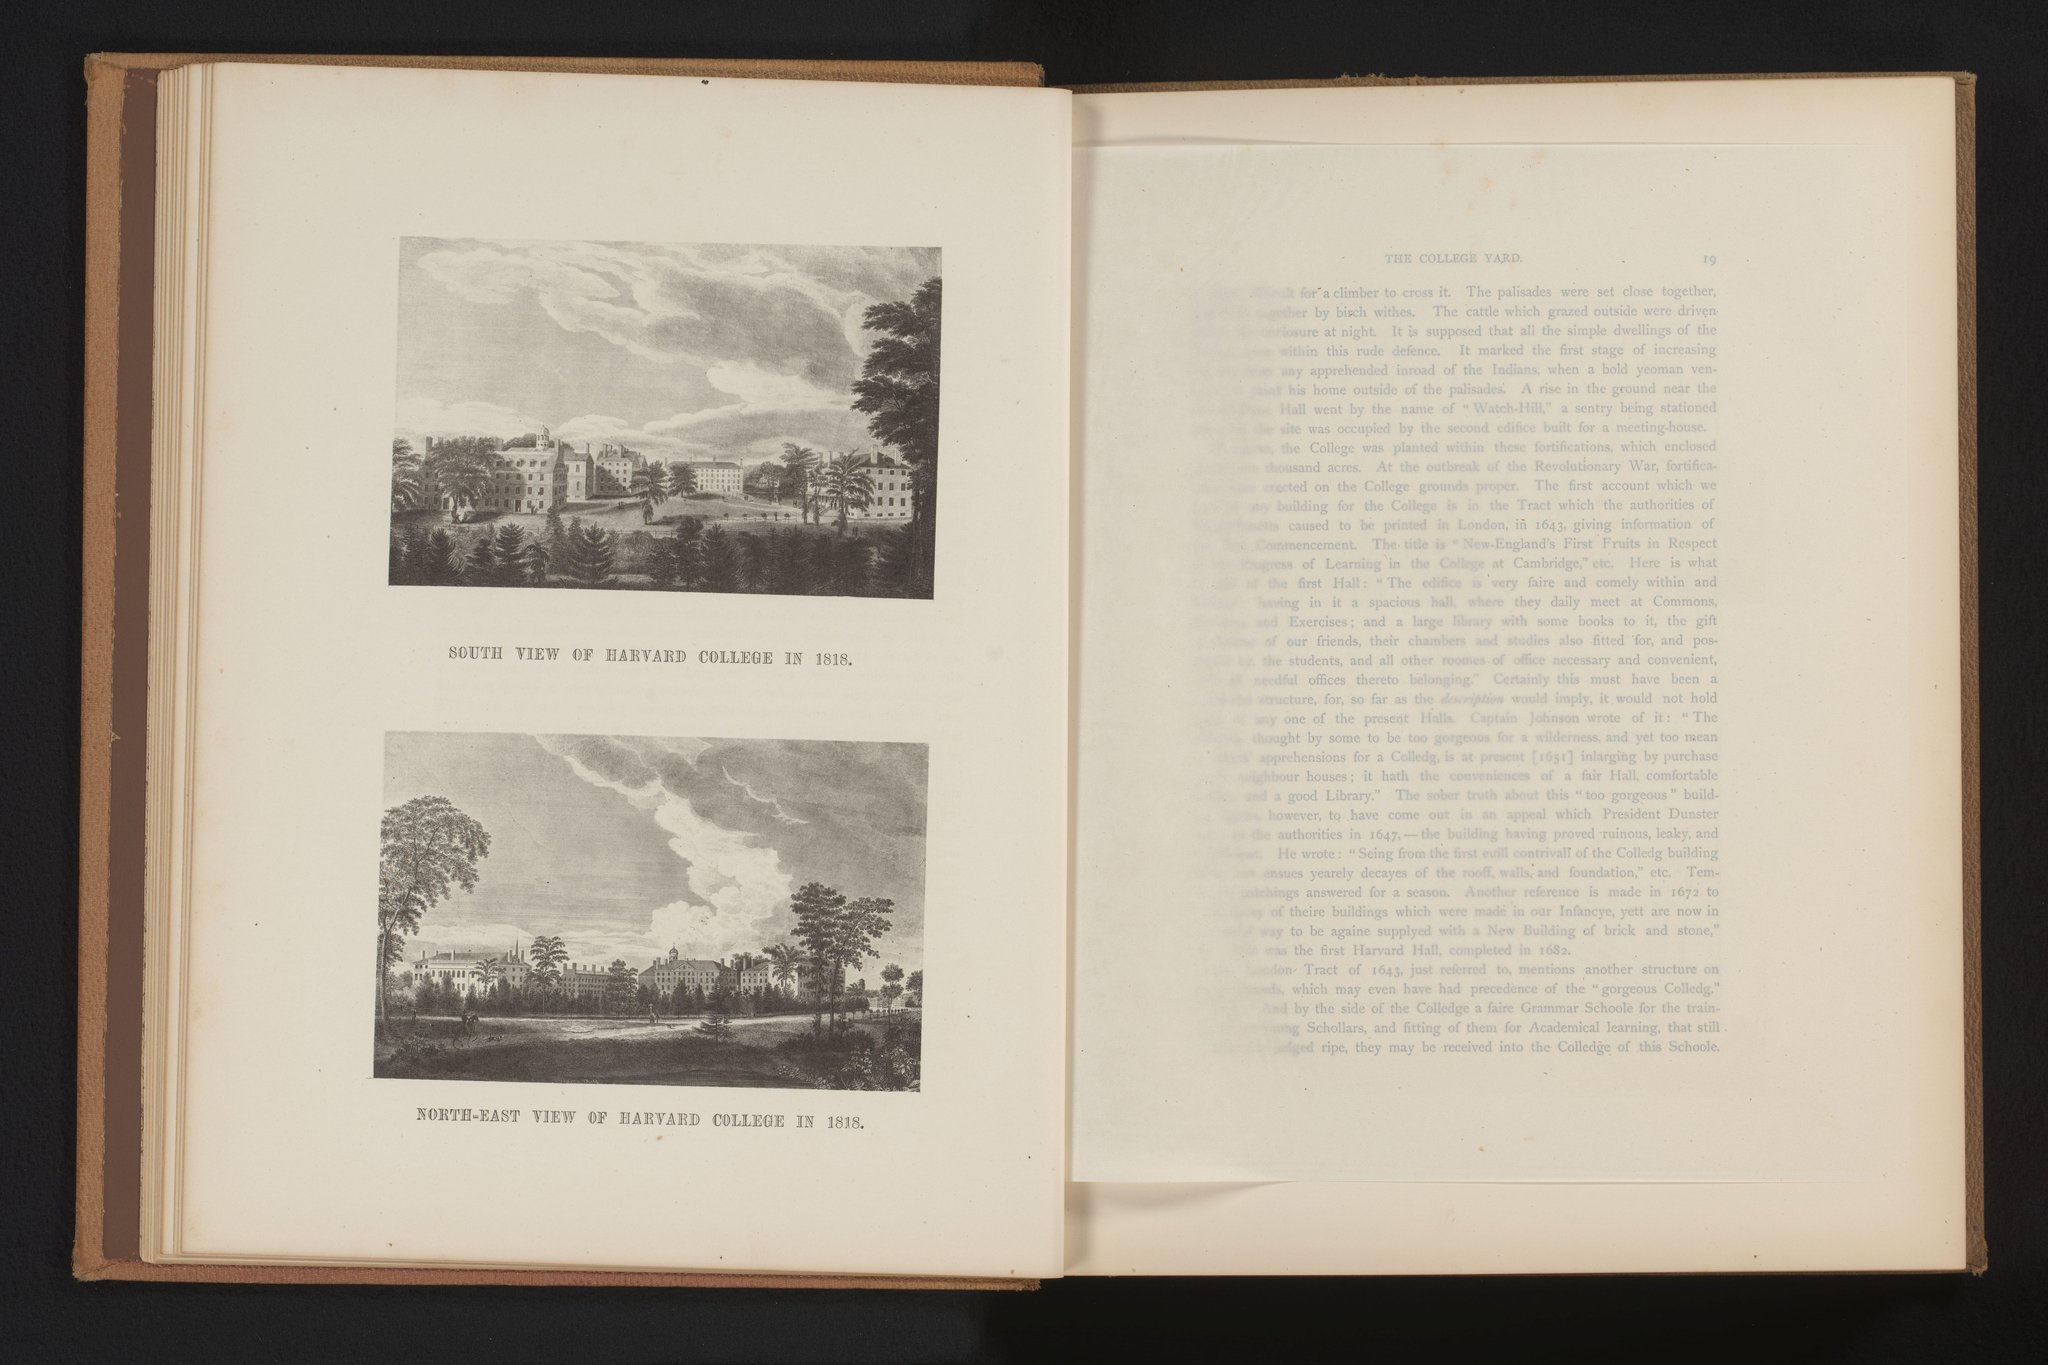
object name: reproduction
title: South view of Harvard College in 1818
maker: Anonymous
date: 1870-1875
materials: paper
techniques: photograph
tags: university building, college, city-view in general; 'veduta' (+ city(-scape) with figures, staffage)